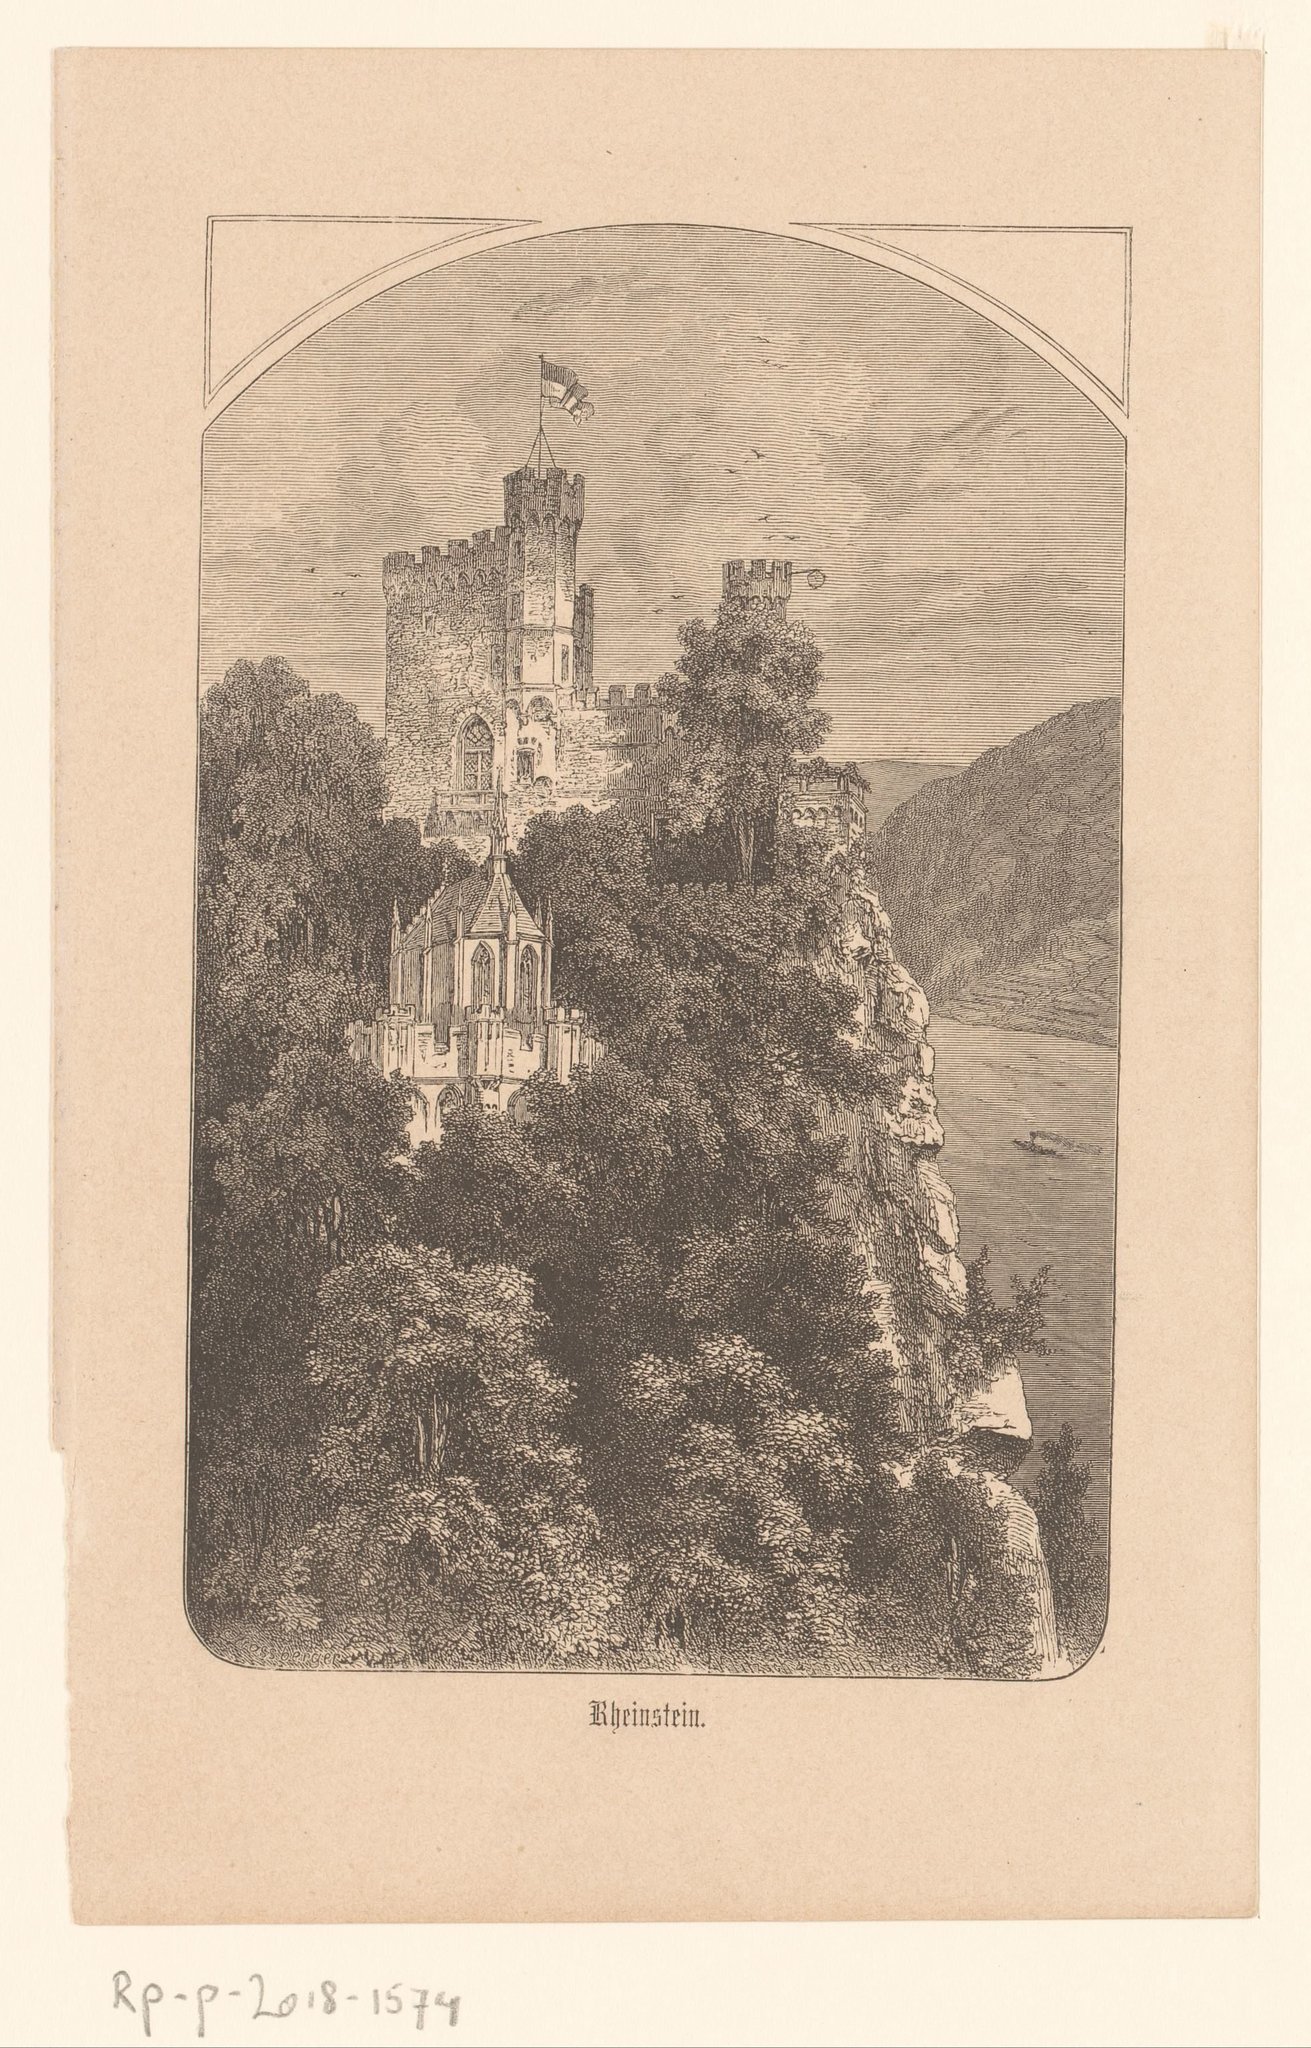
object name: print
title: Rheinstein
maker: Anonymous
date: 1800-1899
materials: paper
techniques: engraving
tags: castle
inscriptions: collector's mark: Lugt 2228